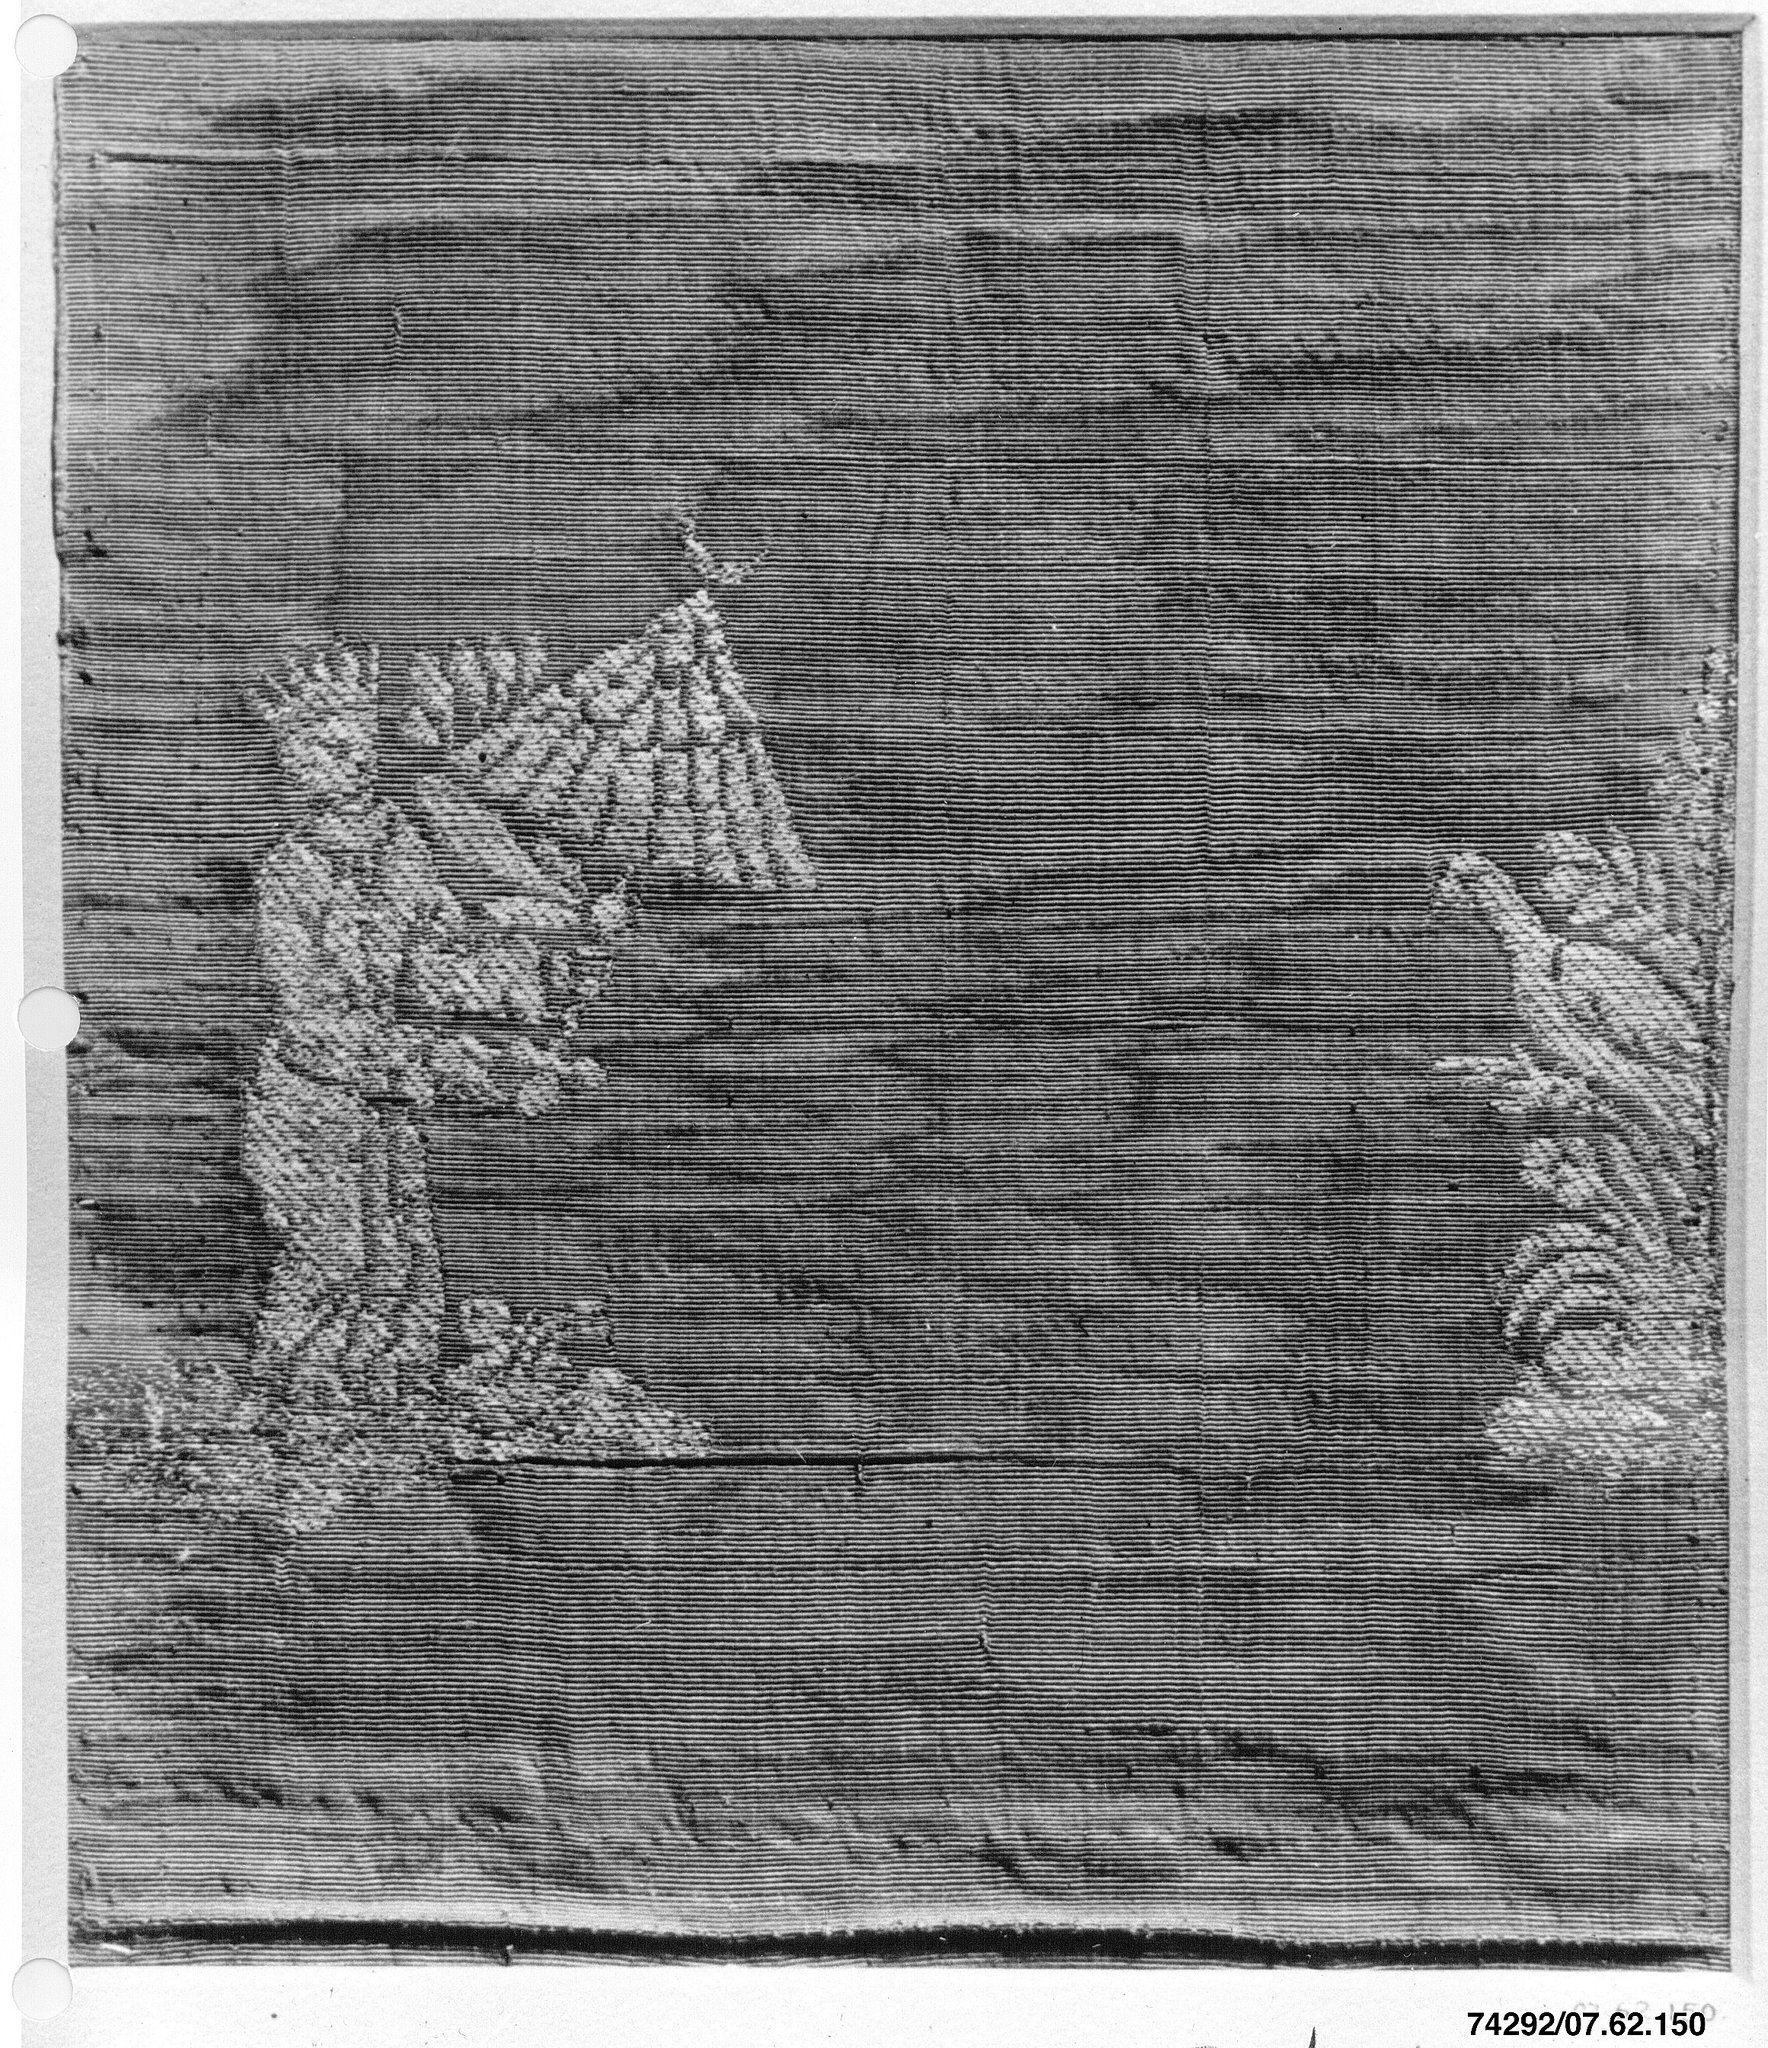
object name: piece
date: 1760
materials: metal thread, silk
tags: birds,men